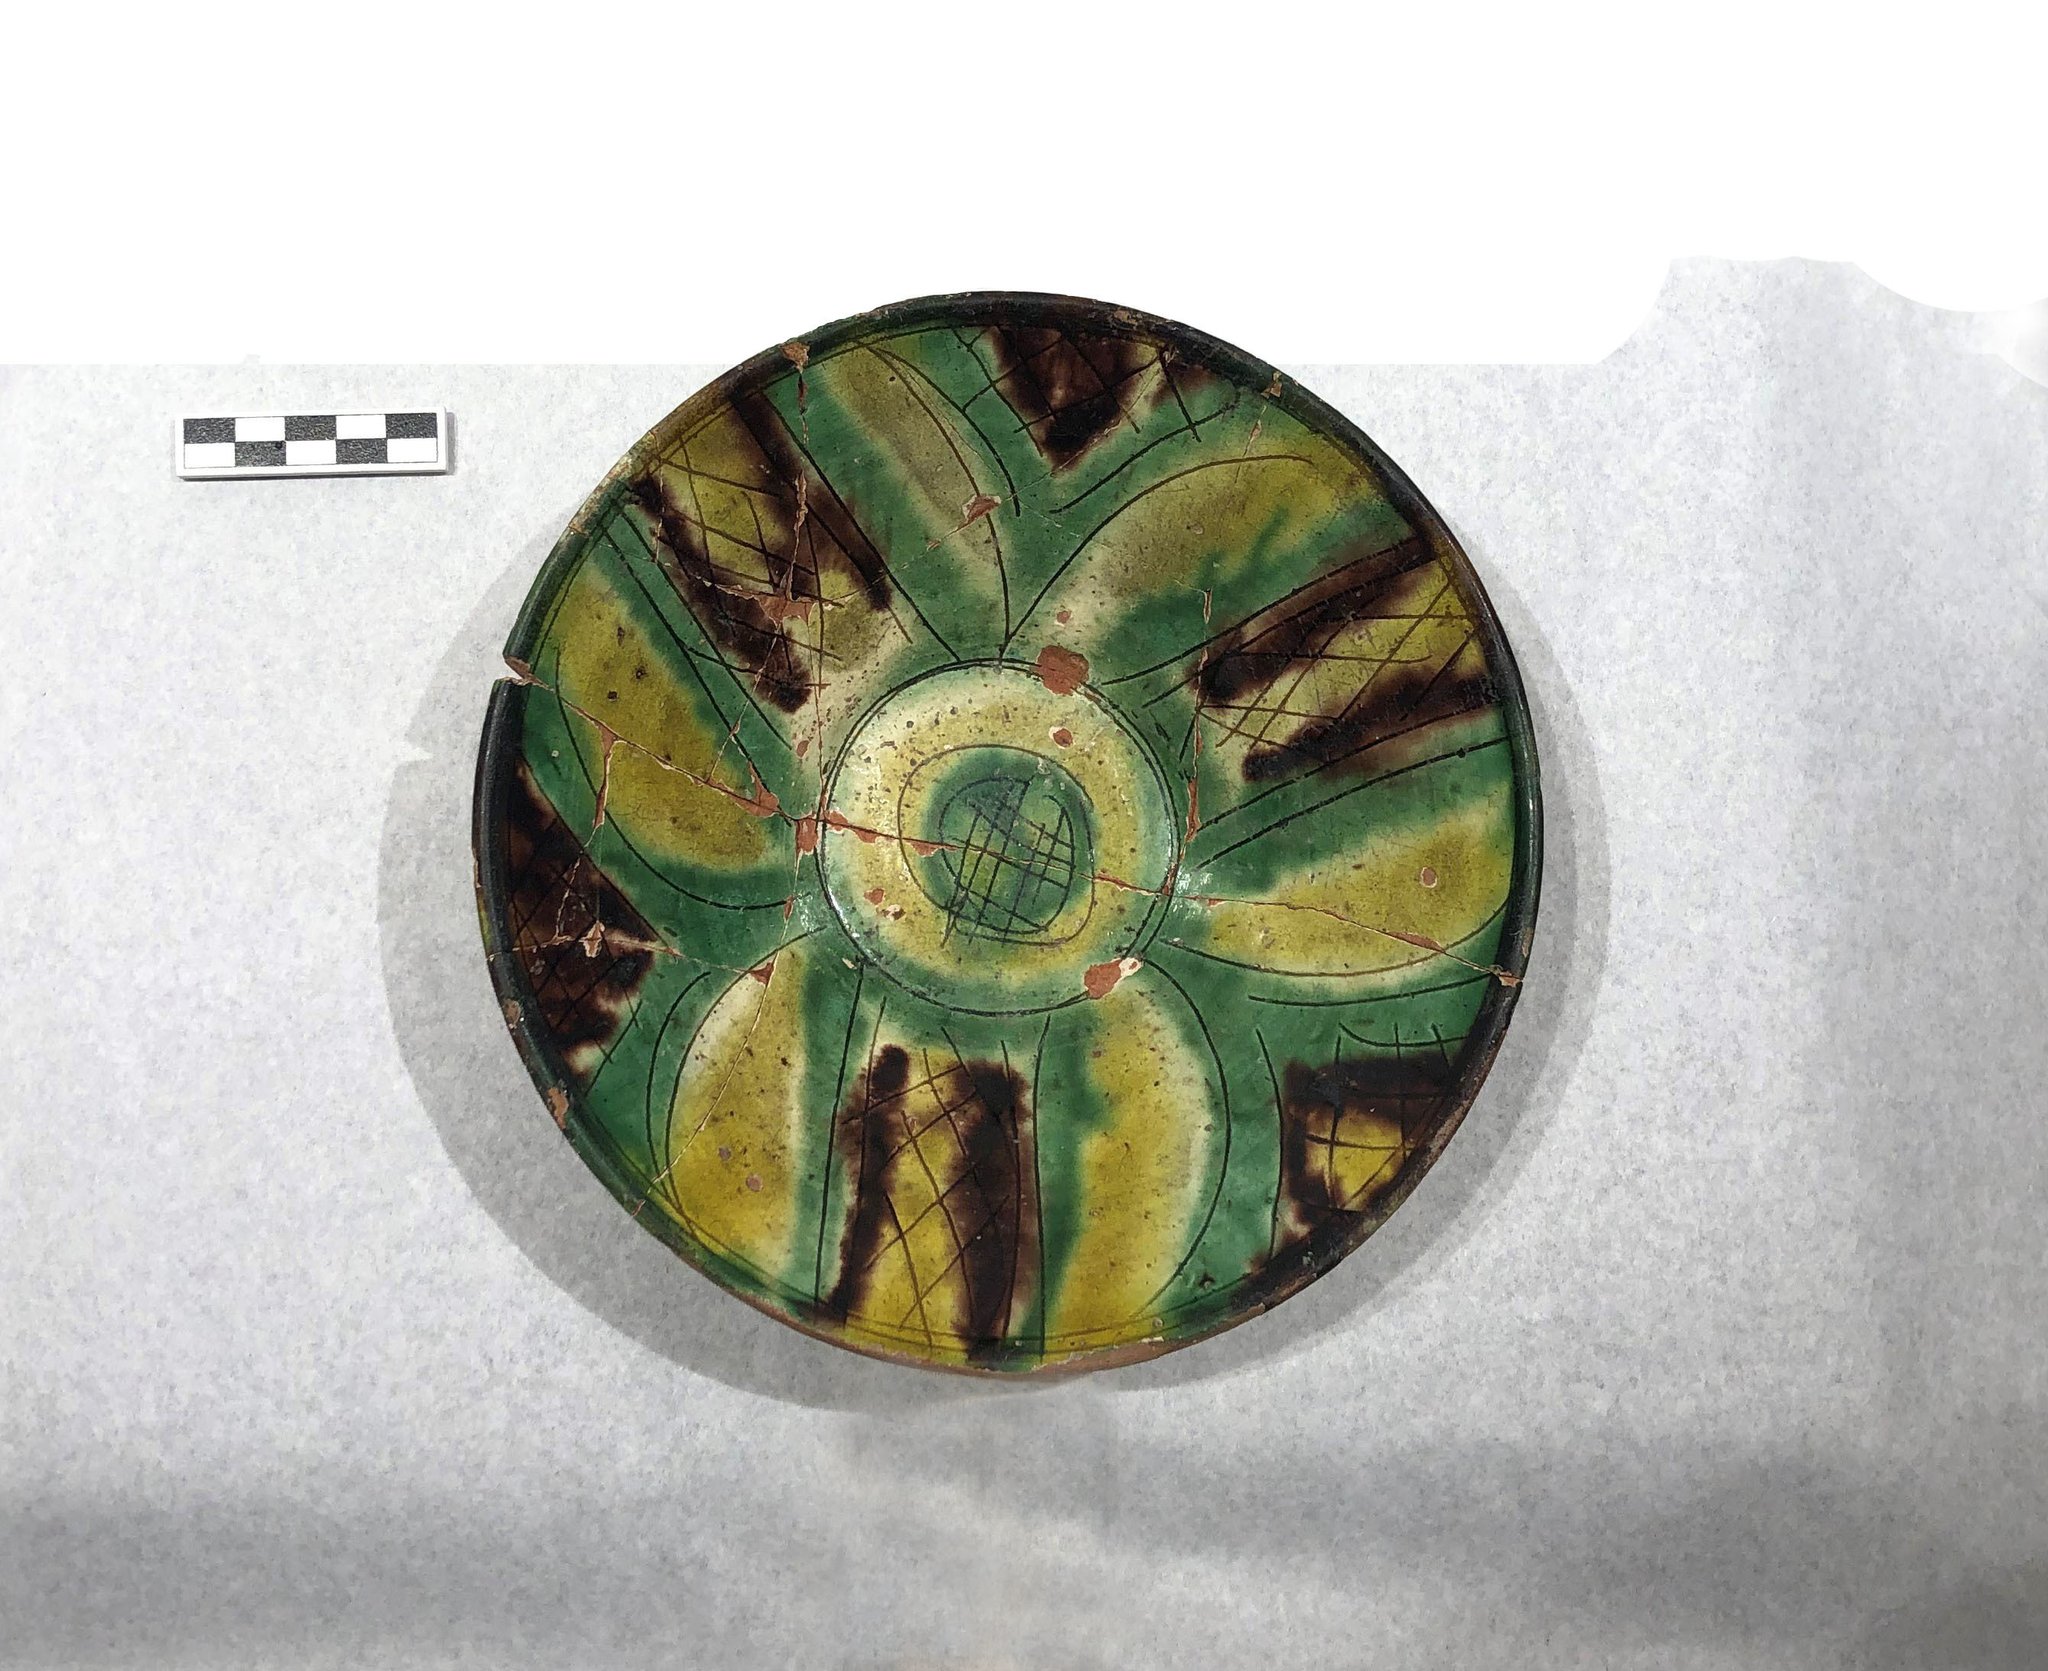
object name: bowl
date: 901-1000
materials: earthenware, glaze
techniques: incising, polychrome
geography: iran